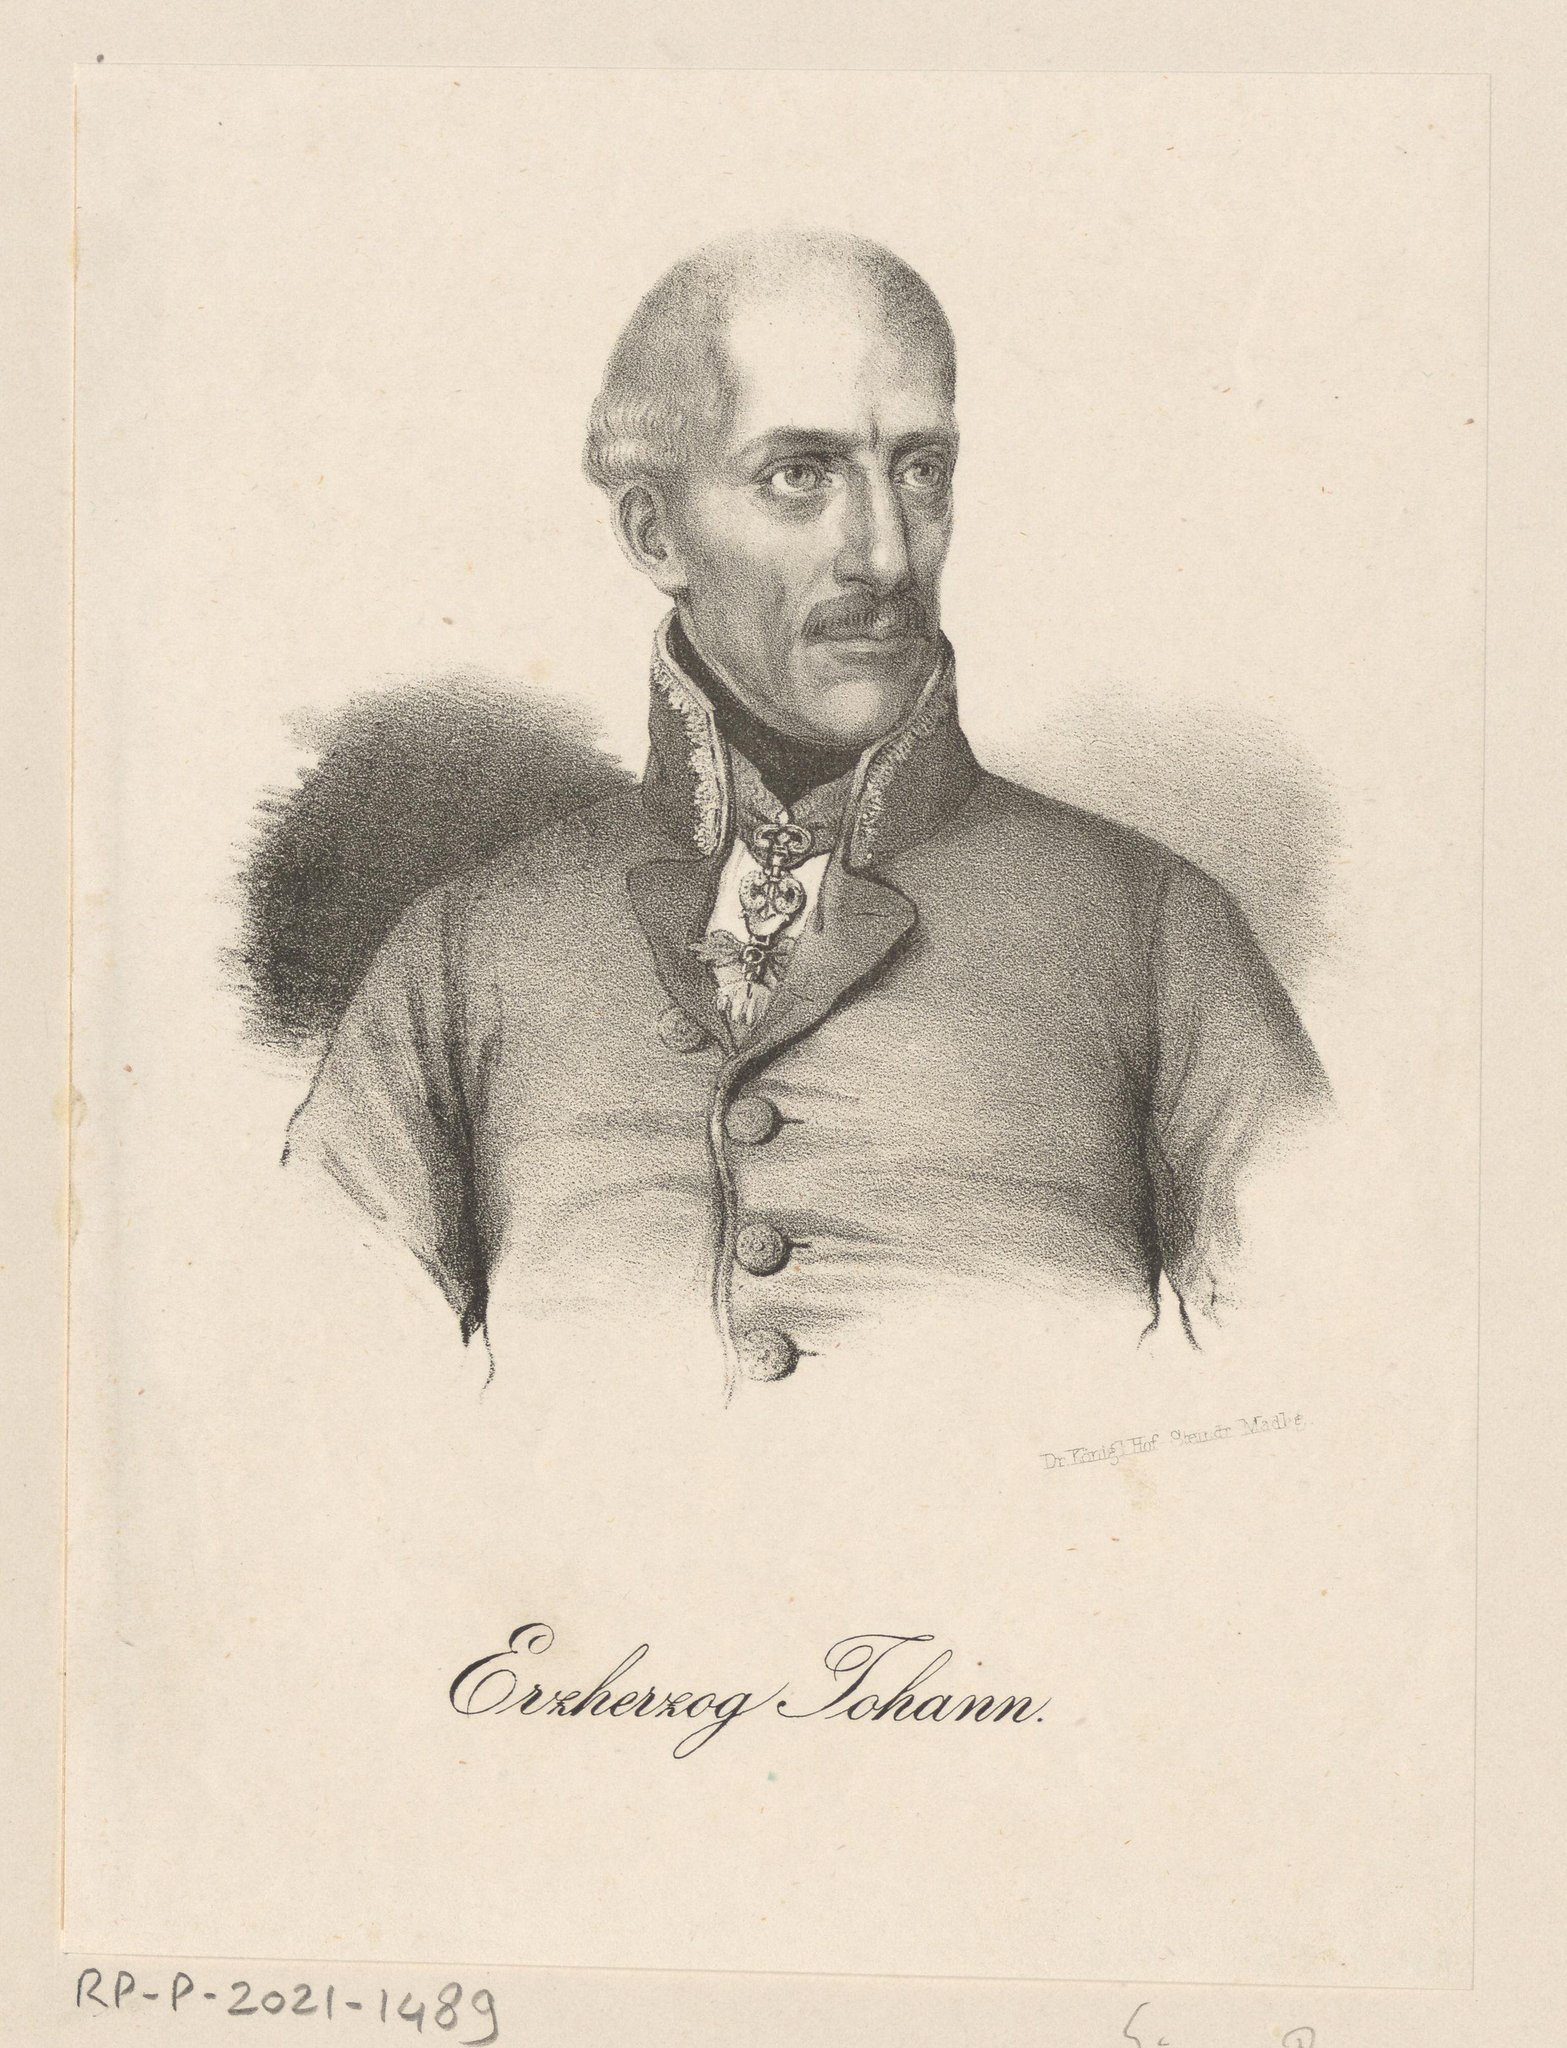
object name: print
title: Portret van Johan van Oostenrijk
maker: Anonymous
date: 1830-1899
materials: paper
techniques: lithograph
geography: magdeburg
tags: commander-in-chief, general, marshal, historical persons, knighthood order of the golden fleece